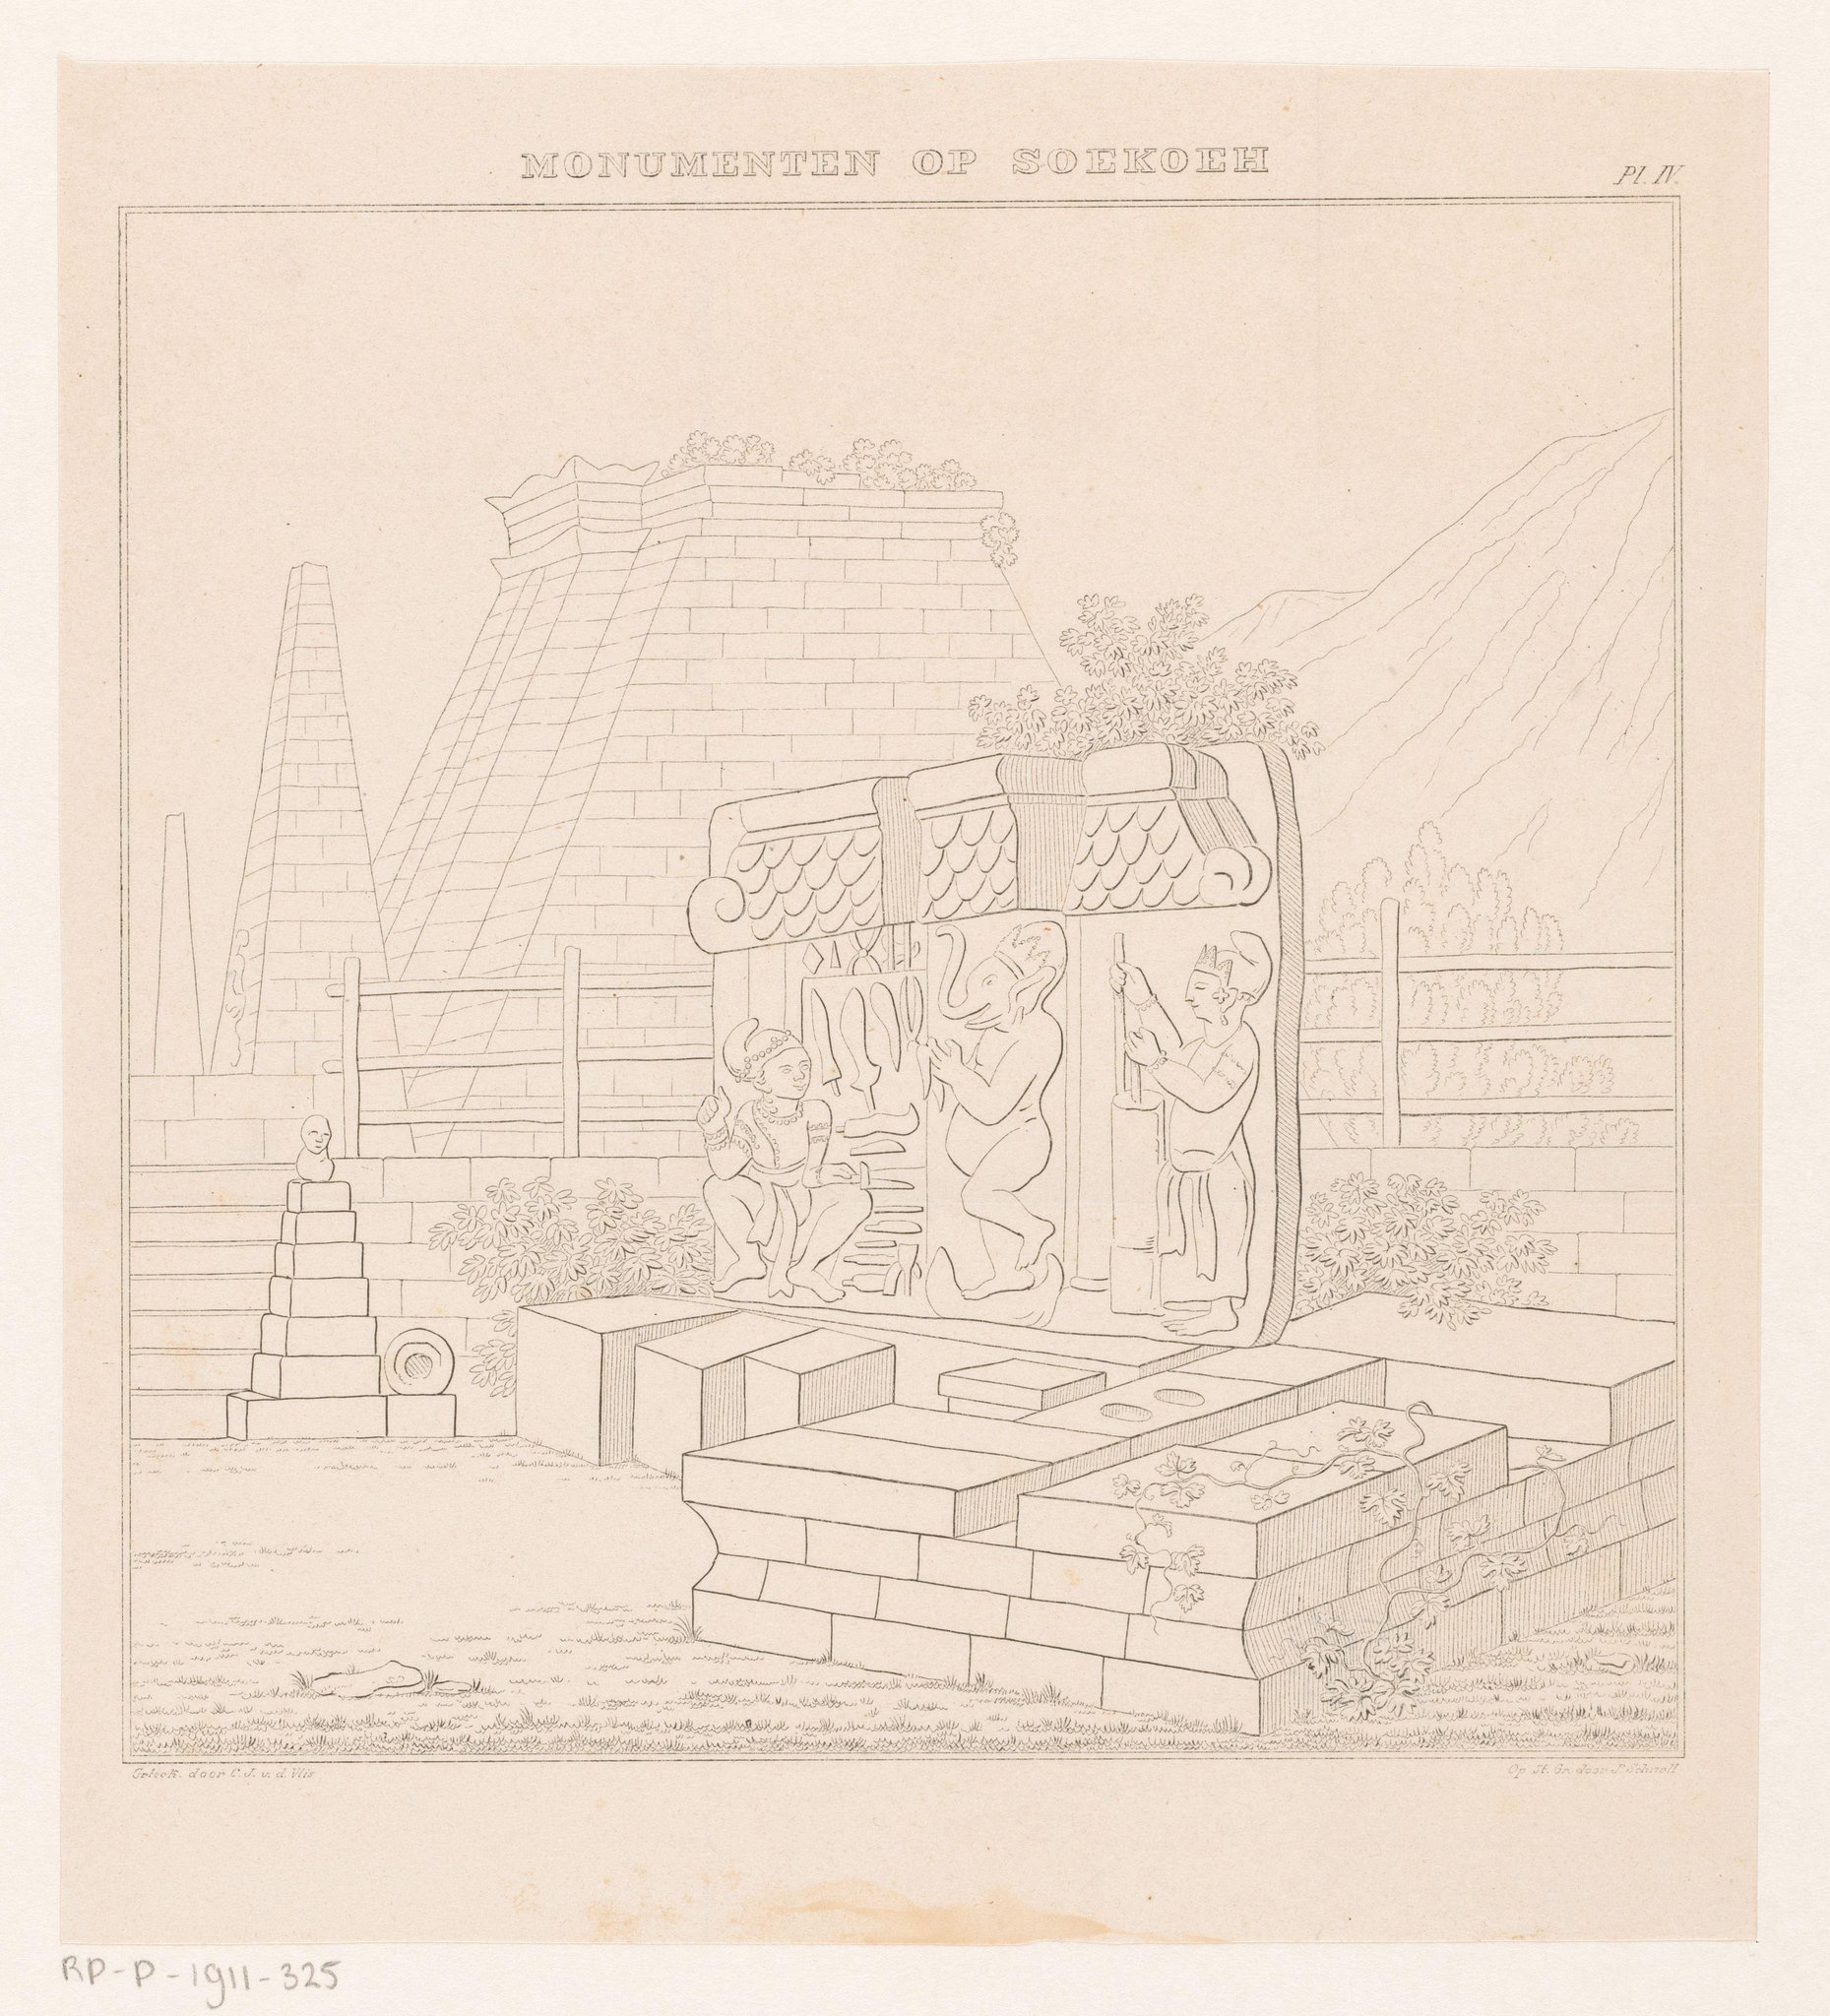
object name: print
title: Monumenten op Soekoeh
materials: paper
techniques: lithograph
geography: netherlands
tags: temple, shrine ~ hinduism, buddhism, jainism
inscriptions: collector's mark: Lugt 2228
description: Prent uit: Vlis, C.J. van der. Verhandelingen van het Bataviaasch genootenschap van Kunsten en Wetenschappen, 19de deel (Proeve eener beschrijving en verklaring der oudheden en opschriften op Soekoeh en Tjetto). Batavia: Bataviaasch Genootschap van Kunsten en Wetenschappen, 1843.